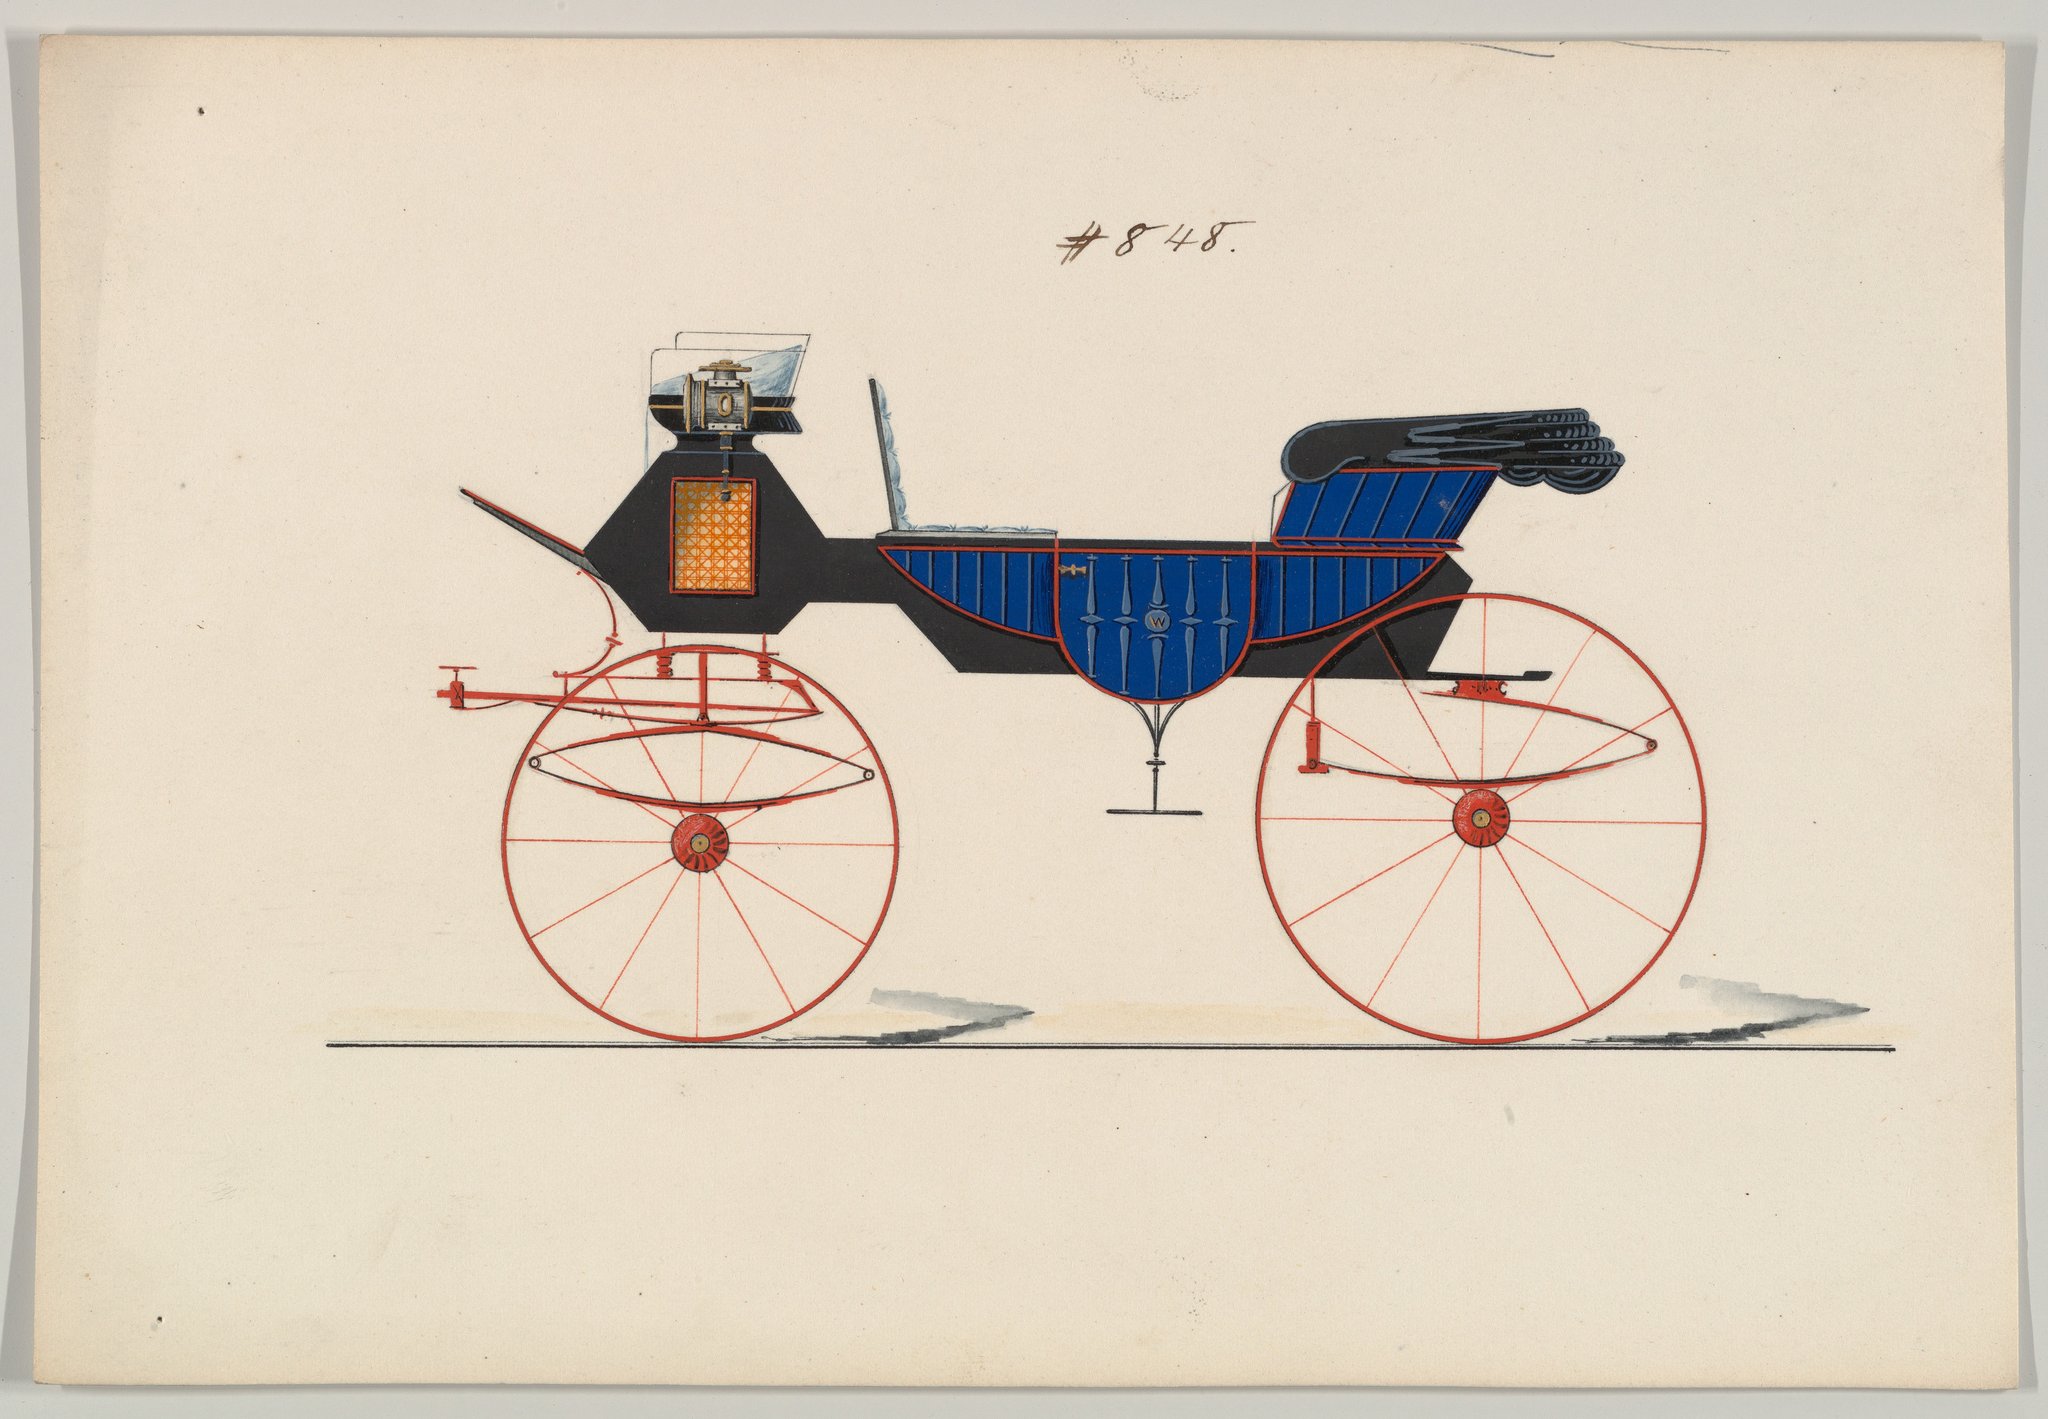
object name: drawing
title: Design for Vis-à-vis/ Charabanc, no. 848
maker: brewster & co.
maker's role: manufacturer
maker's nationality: american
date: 1850-1870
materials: ink, watercolor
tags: carriages